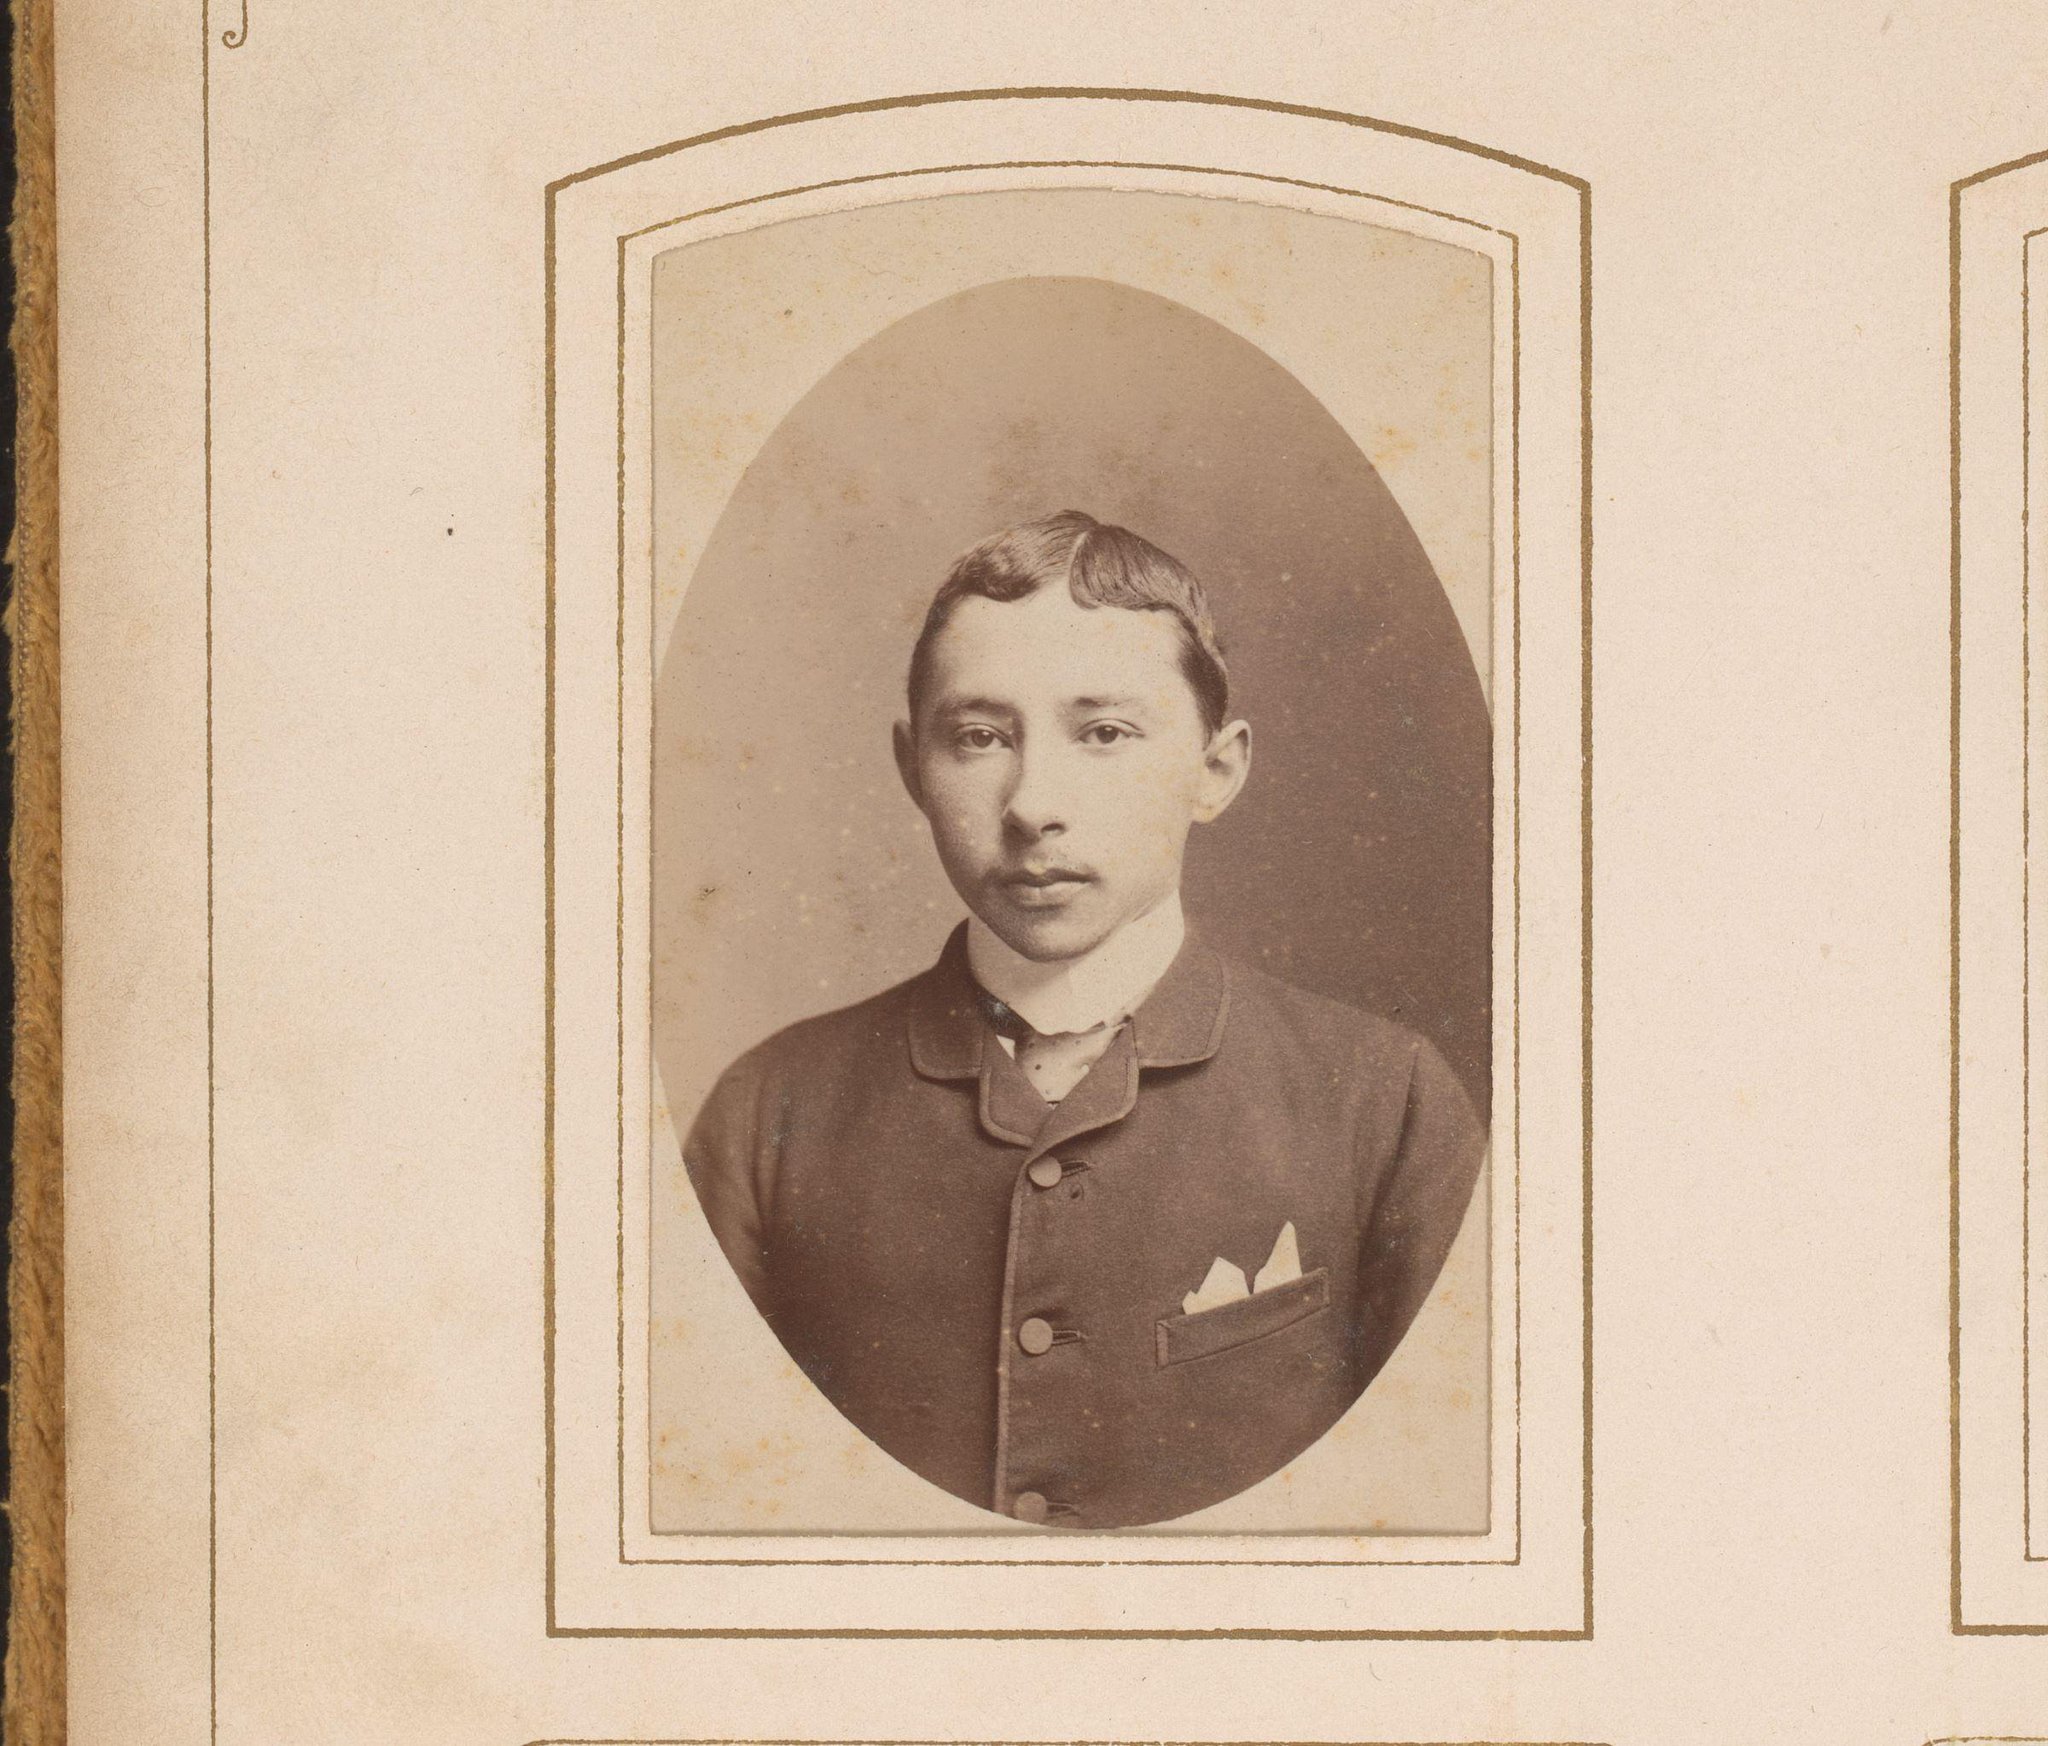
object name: photograph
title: Portret van een jongen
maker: jan goedeljee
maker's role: fotograaf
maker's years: 1824-1905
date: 1880-1883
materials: cardboard, photographic support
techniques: albumen print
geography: leiden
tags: boy (child between toddler and youth), historical persons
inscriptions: inscription: ‘J. Goedeljee/ Photograaf/ van/ Z. K. H. PRINS ALEXANDER/ der Nederlanden/ PRINS van ORANJE/ en H. K. H./ PRINSES HENDRIK/ der Nederlanden./ LEIDEN/ Hoogewoerd 160/ nabij de Plantage.’